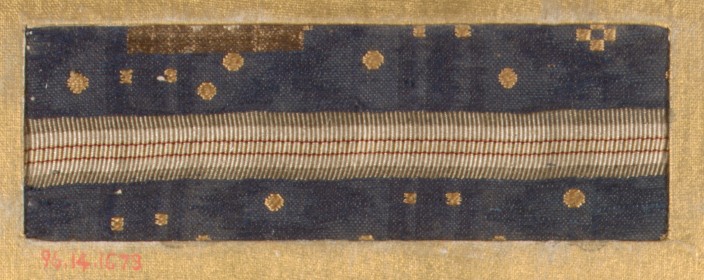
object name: piece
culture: japanese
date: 1701-1900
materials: silk